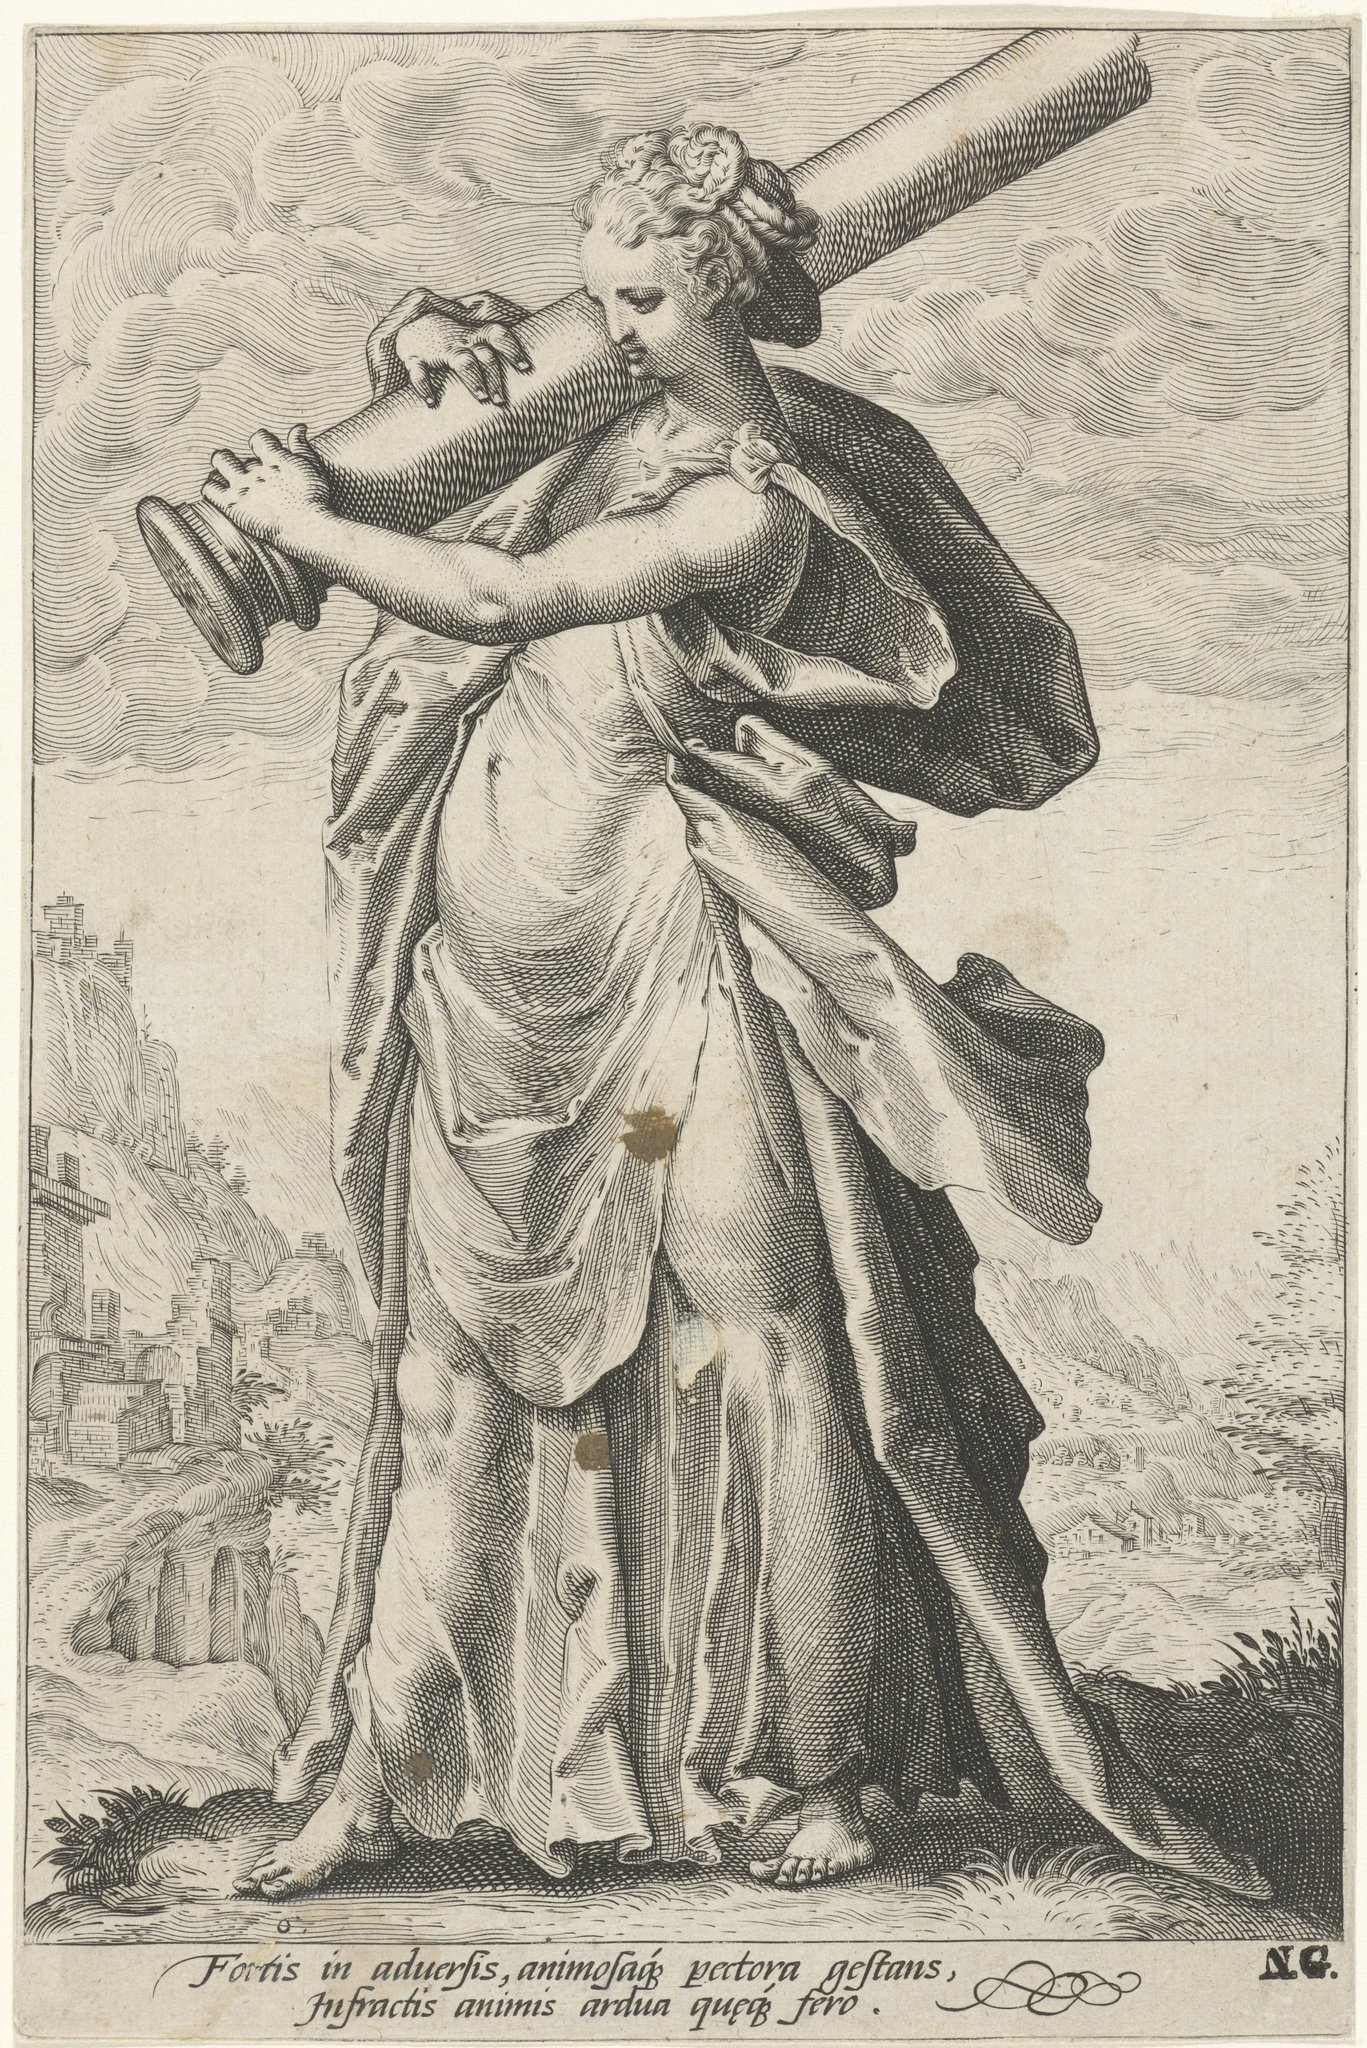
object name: print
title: De deugden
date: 1585-1589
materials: paper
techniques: engraving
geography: haarlem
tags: fortitude, 'fortitudo' ~ one of the four cardinal virtues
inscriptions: collector's mark: Lugt 2228, collector's mark: Lugt 1967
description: De gepersonifieerde Kracht; een vrouwenfiguur met een zuil over haar rechter schouder. Op de achtergrond een heuvellandschap.